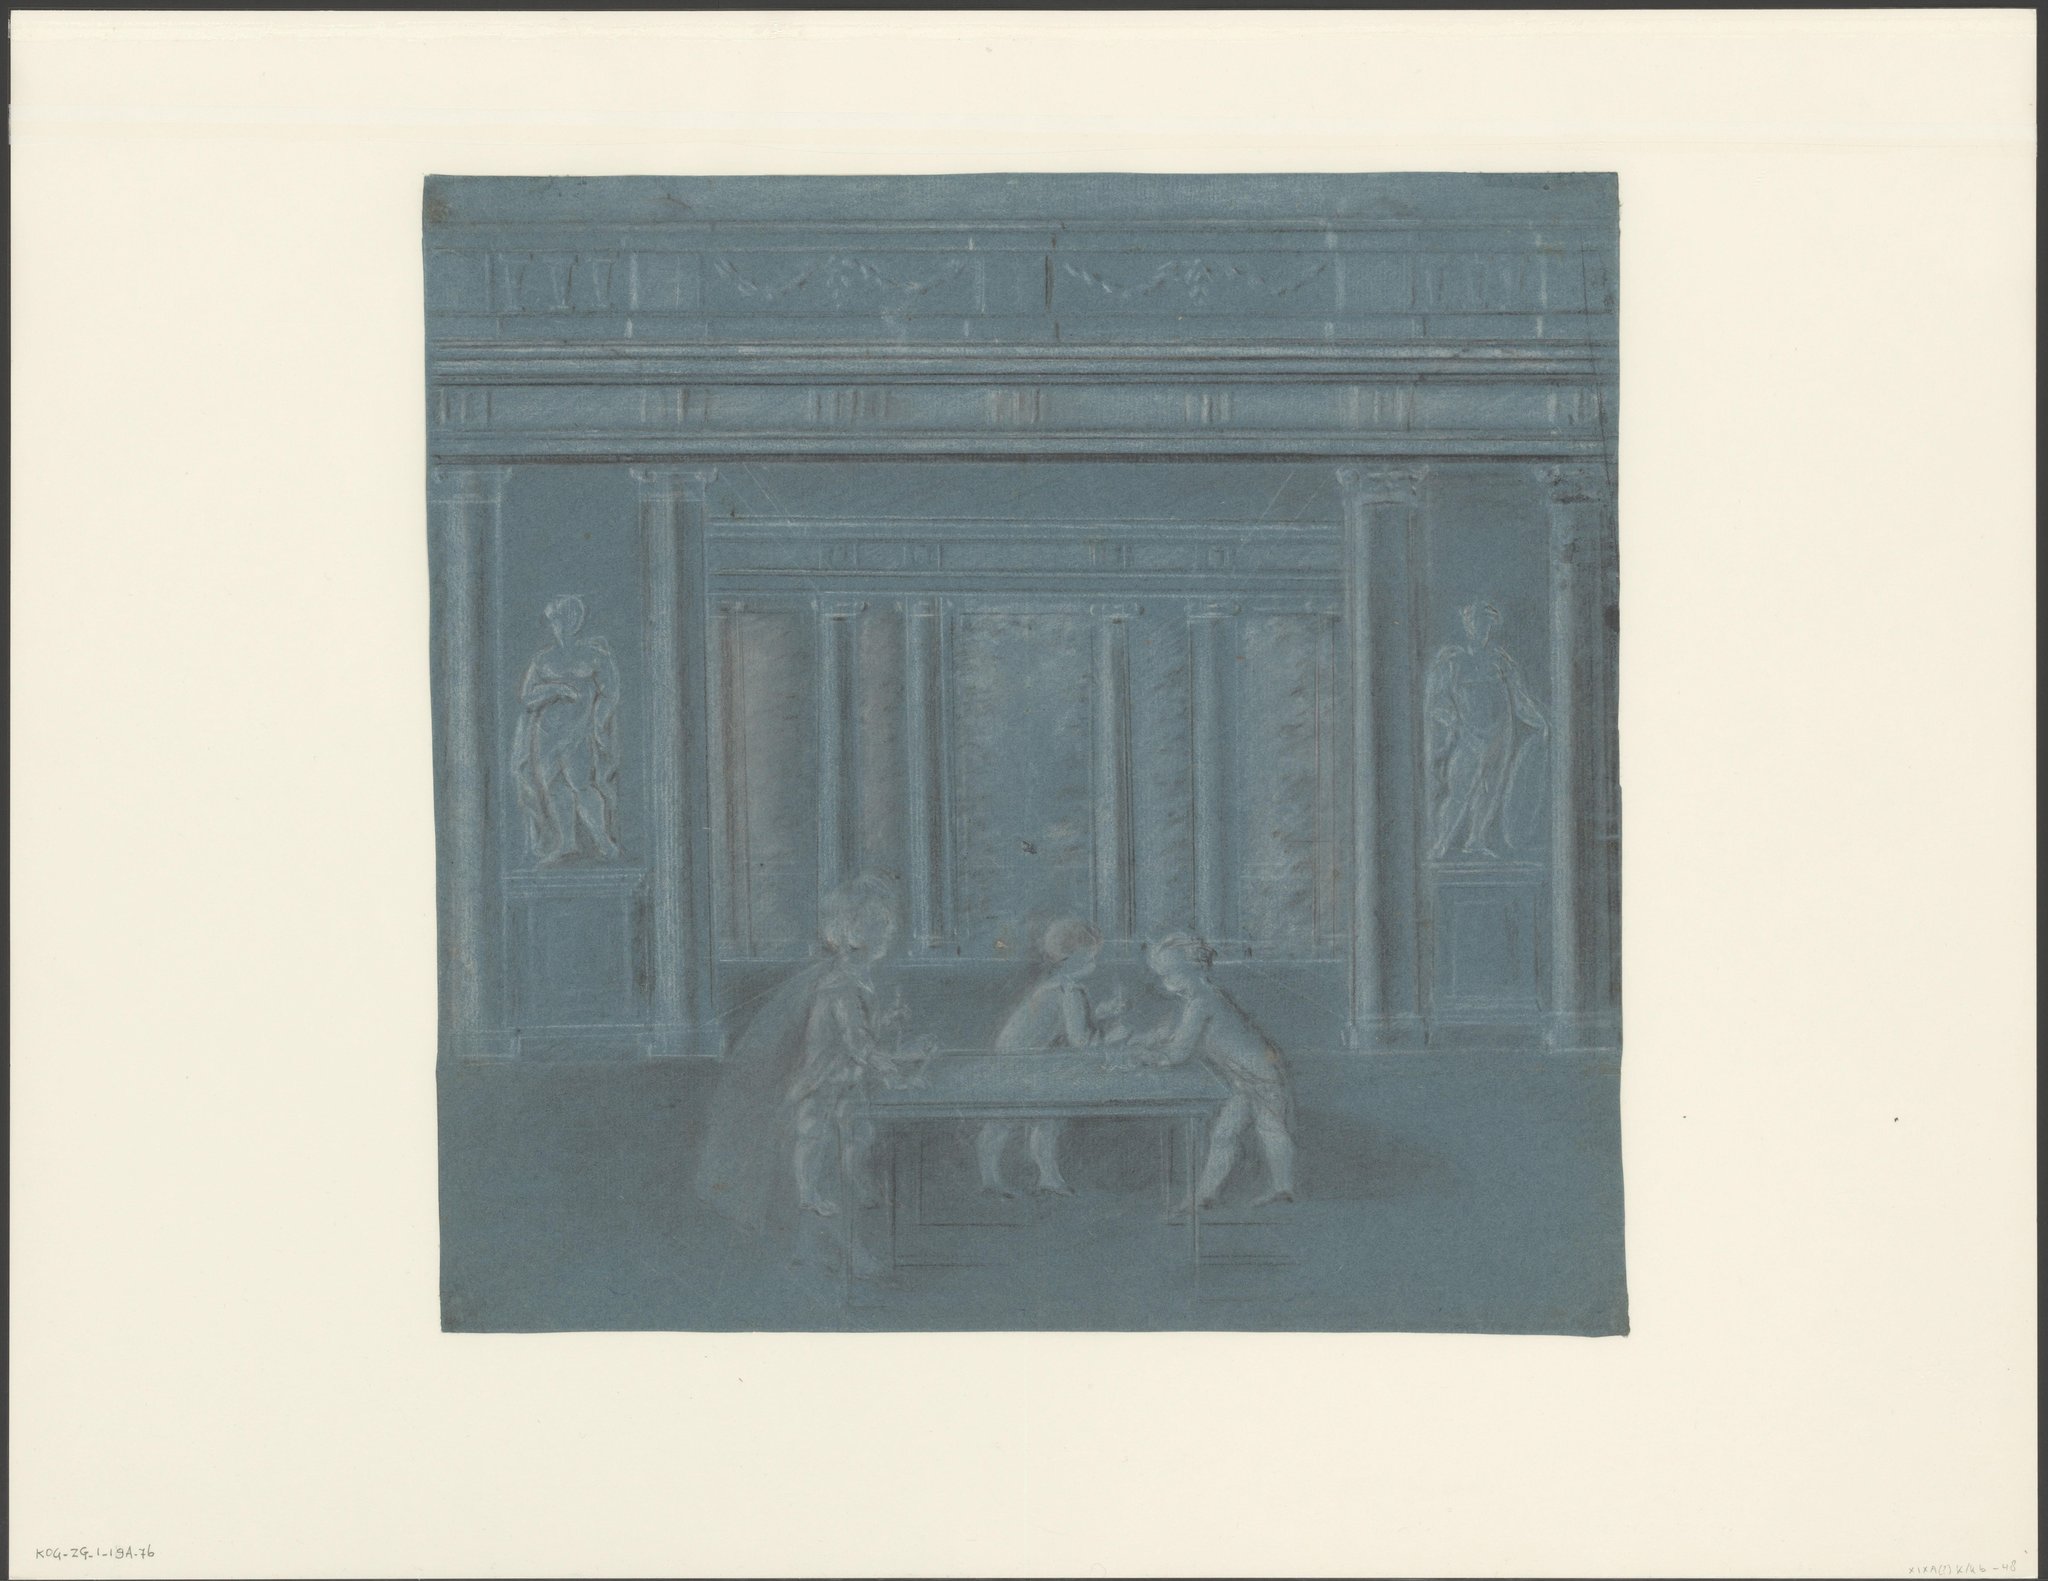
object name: drawing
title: Drie kinderen spelen aan een tafel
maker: Anonymous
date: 1800-1899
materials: chalk, paper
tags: children's games and plays, child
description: Onderwerpsrubrieken binnen de Atlas Zeden en Gewoonten: Zeden en Gewoonten in Engeren Zin, Des menschen beging, midden en einde, Kinderleven – Kinderspel en Kinderprenten.